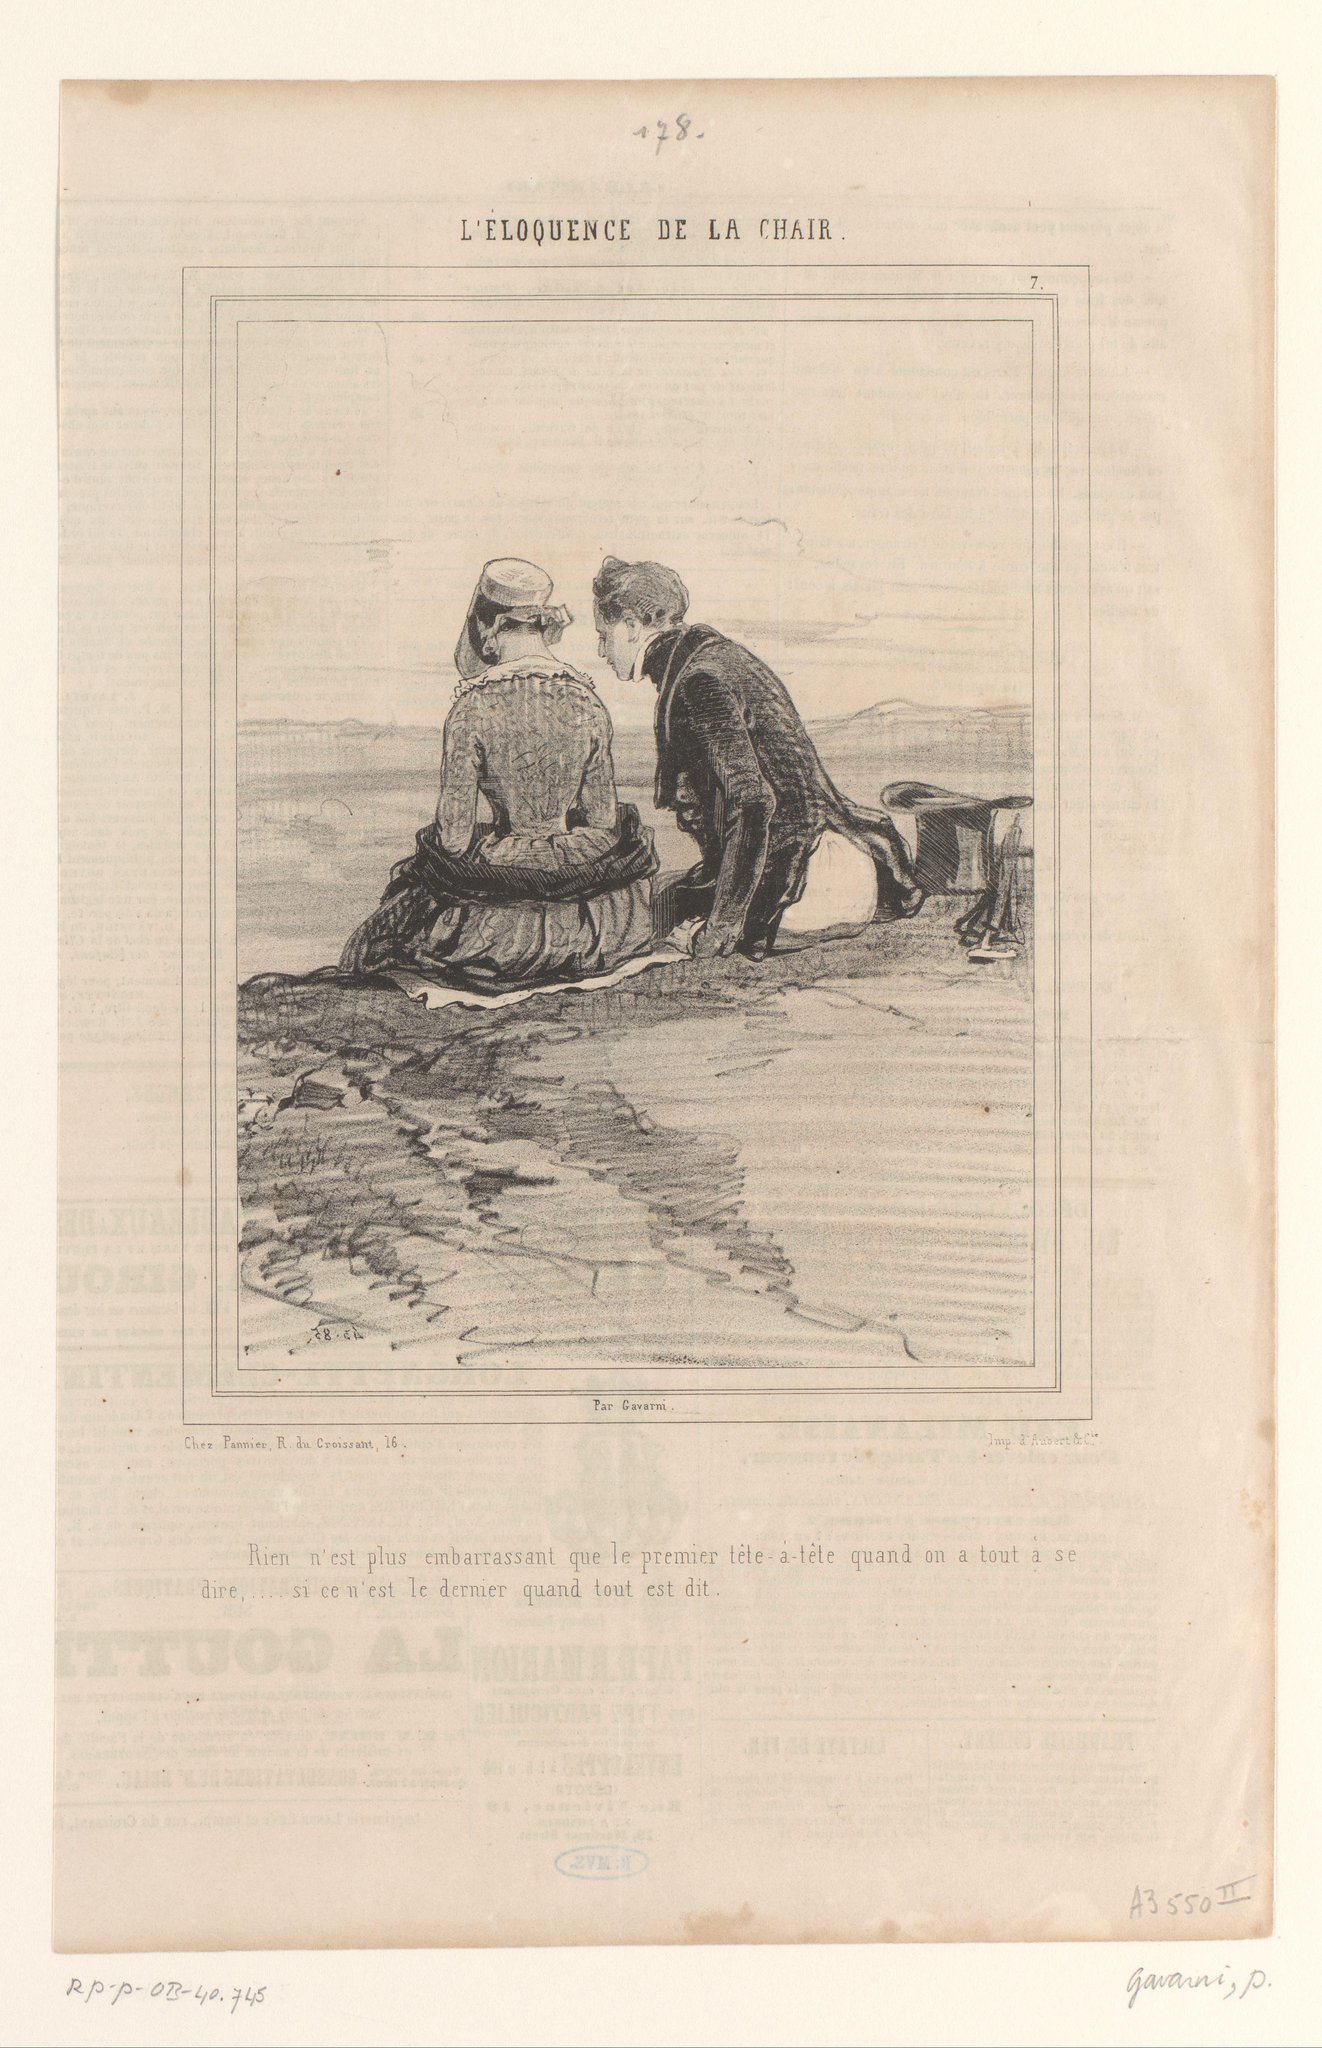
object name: print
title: Rien n'est plus embarrassant que le premier tête-à-tête (...)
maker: paul gavarni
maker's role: draughtsman, print maker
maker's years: 1804-1866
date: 1843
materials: paper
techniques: lithograph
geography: paris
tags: low hill country (+ landscape with figures, staffage), lovers' meeting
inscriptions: collector's mark: Lugt 2228a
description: Prent gebruikt voor: Le Charivari, 18 september 1843.